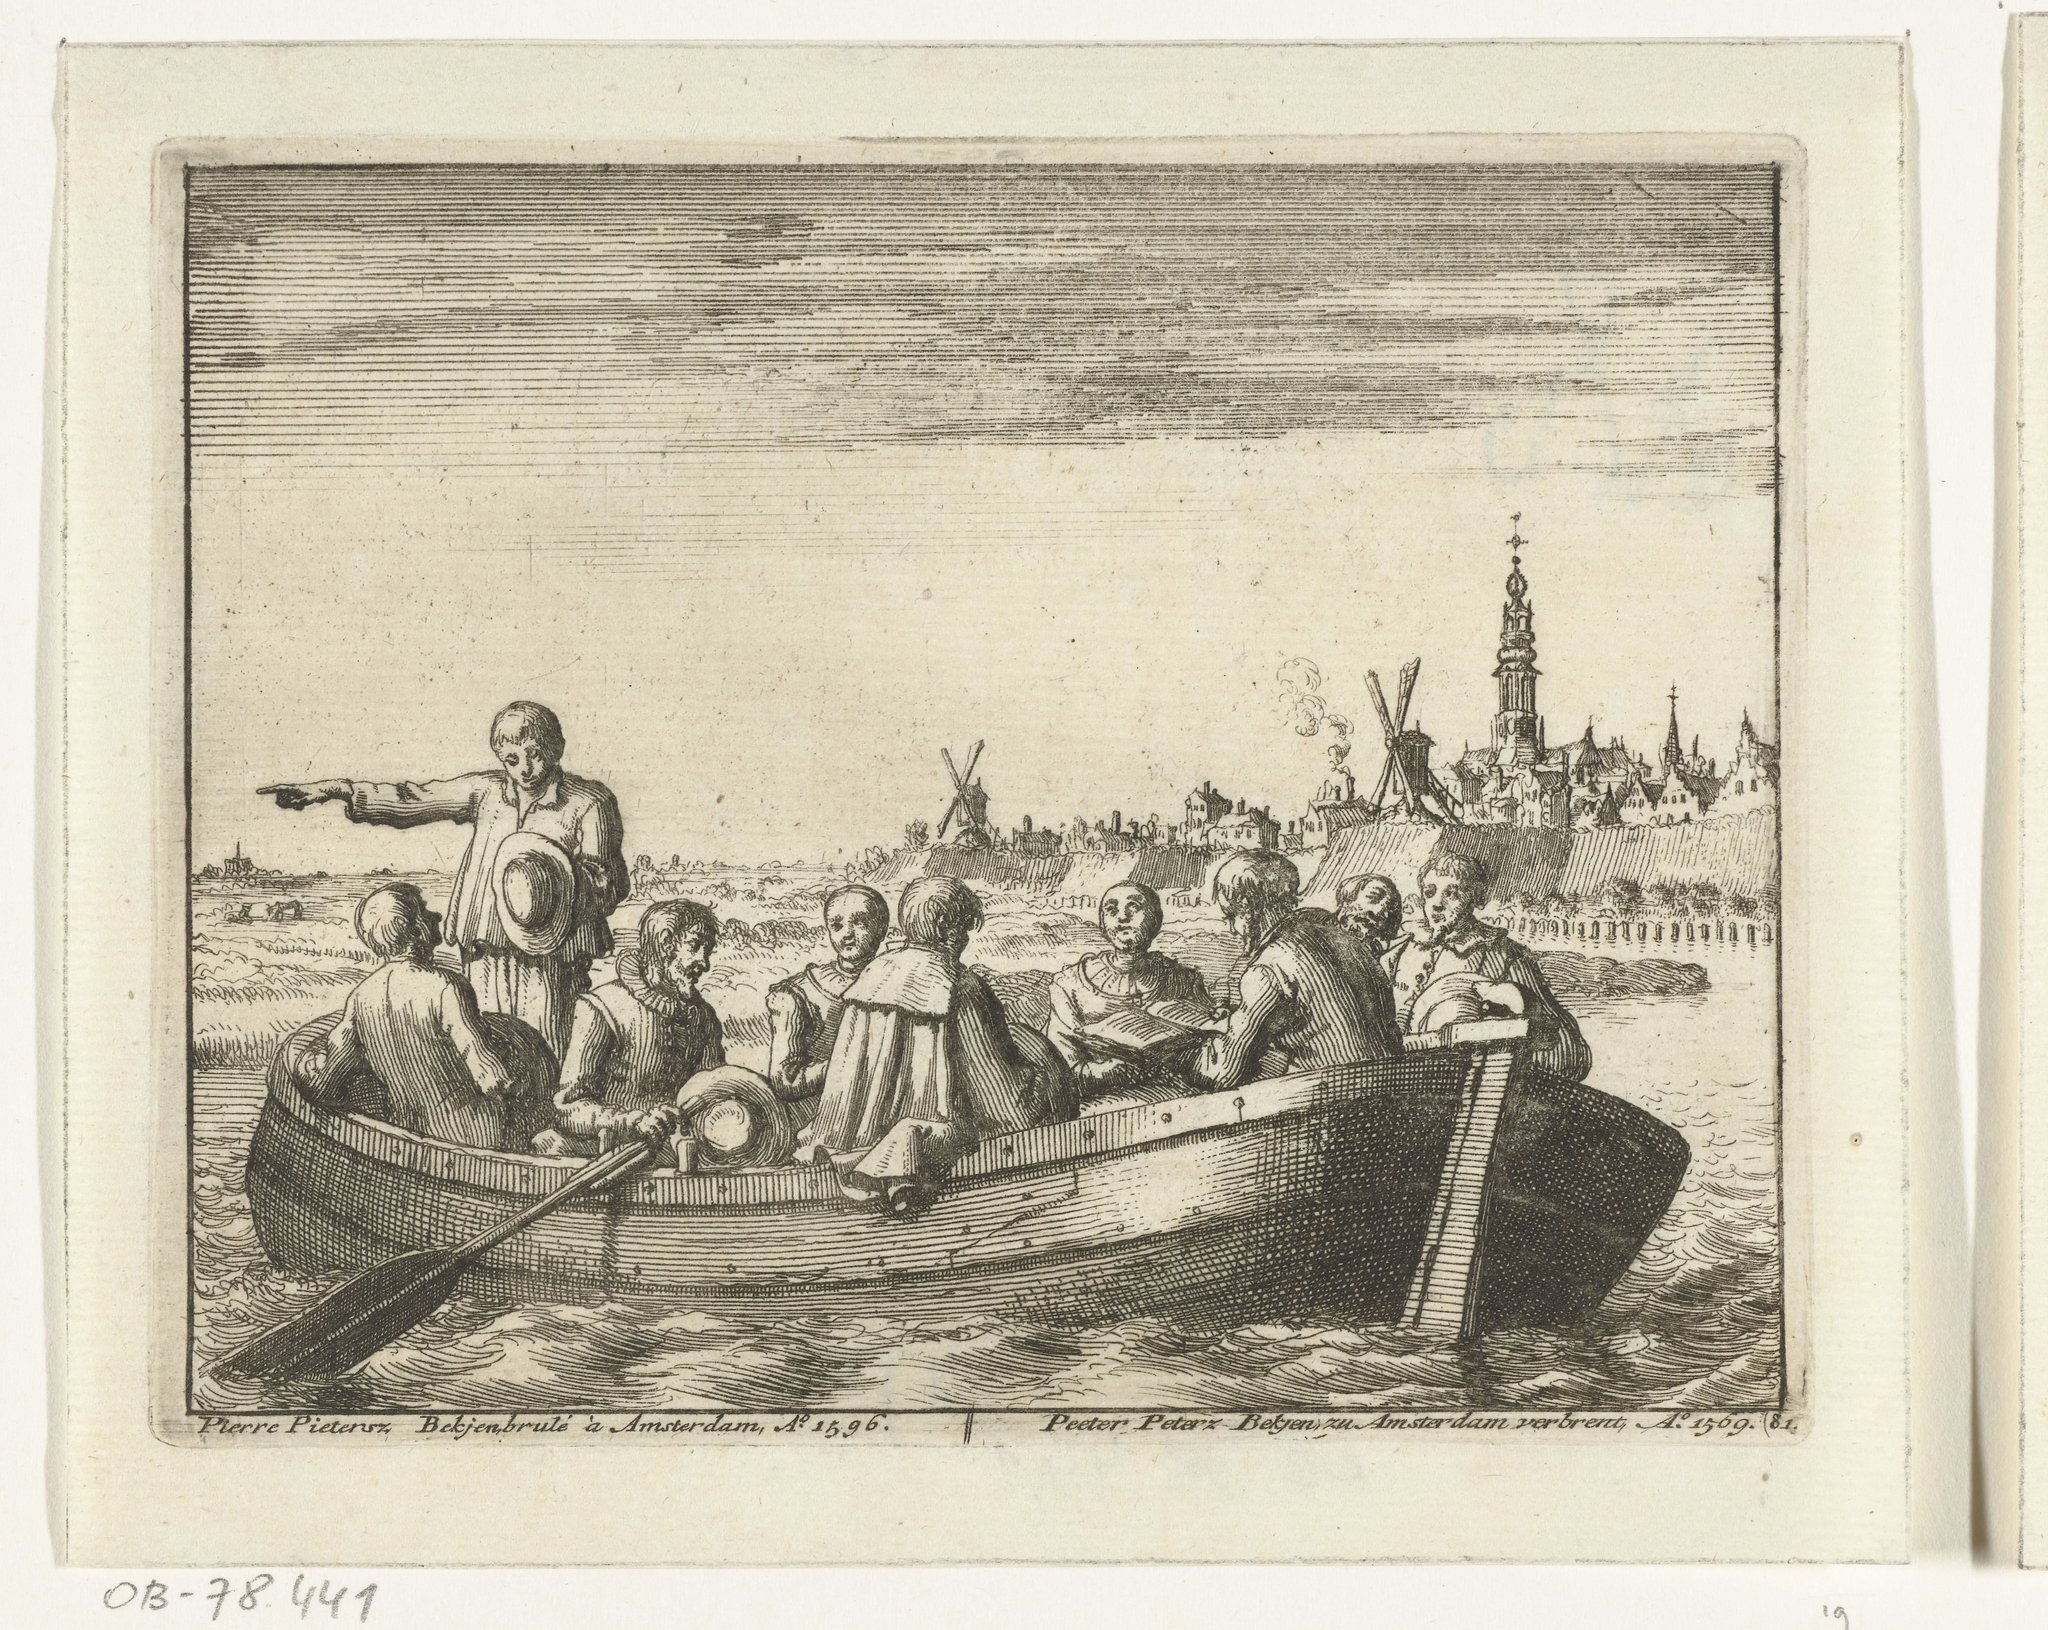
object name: print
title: Pieter Pietersz. Bekjen leest voor uit de Bijbel in een schuit op de Amstel buiten de Regulierspoort te Amsterdam, 1569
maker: jan luyken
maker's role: draughtsman, print maker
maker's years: 1649-1712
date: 1683-1685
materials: paper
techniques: etching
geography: northern netherlands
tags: preaching (in general), persecution of heretics, amsterdam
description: De prenten in deze tweede staat gebruikt als illustratie voor: Theatre des martyrs, depuis la mort de J. Christ jusqu'à present (...). = Schau-buhne der Martyrer, P. van der Aa, Leiden ca. 1715, nr. 81. De prenten zijn oorspronkelijk vervaardigd voor en eerst gebruikt in: T.J. van Bragt, Het bloedig tooneel, of Martelaers spiegel der doops-gesinde of weereloose christenen, 1685.